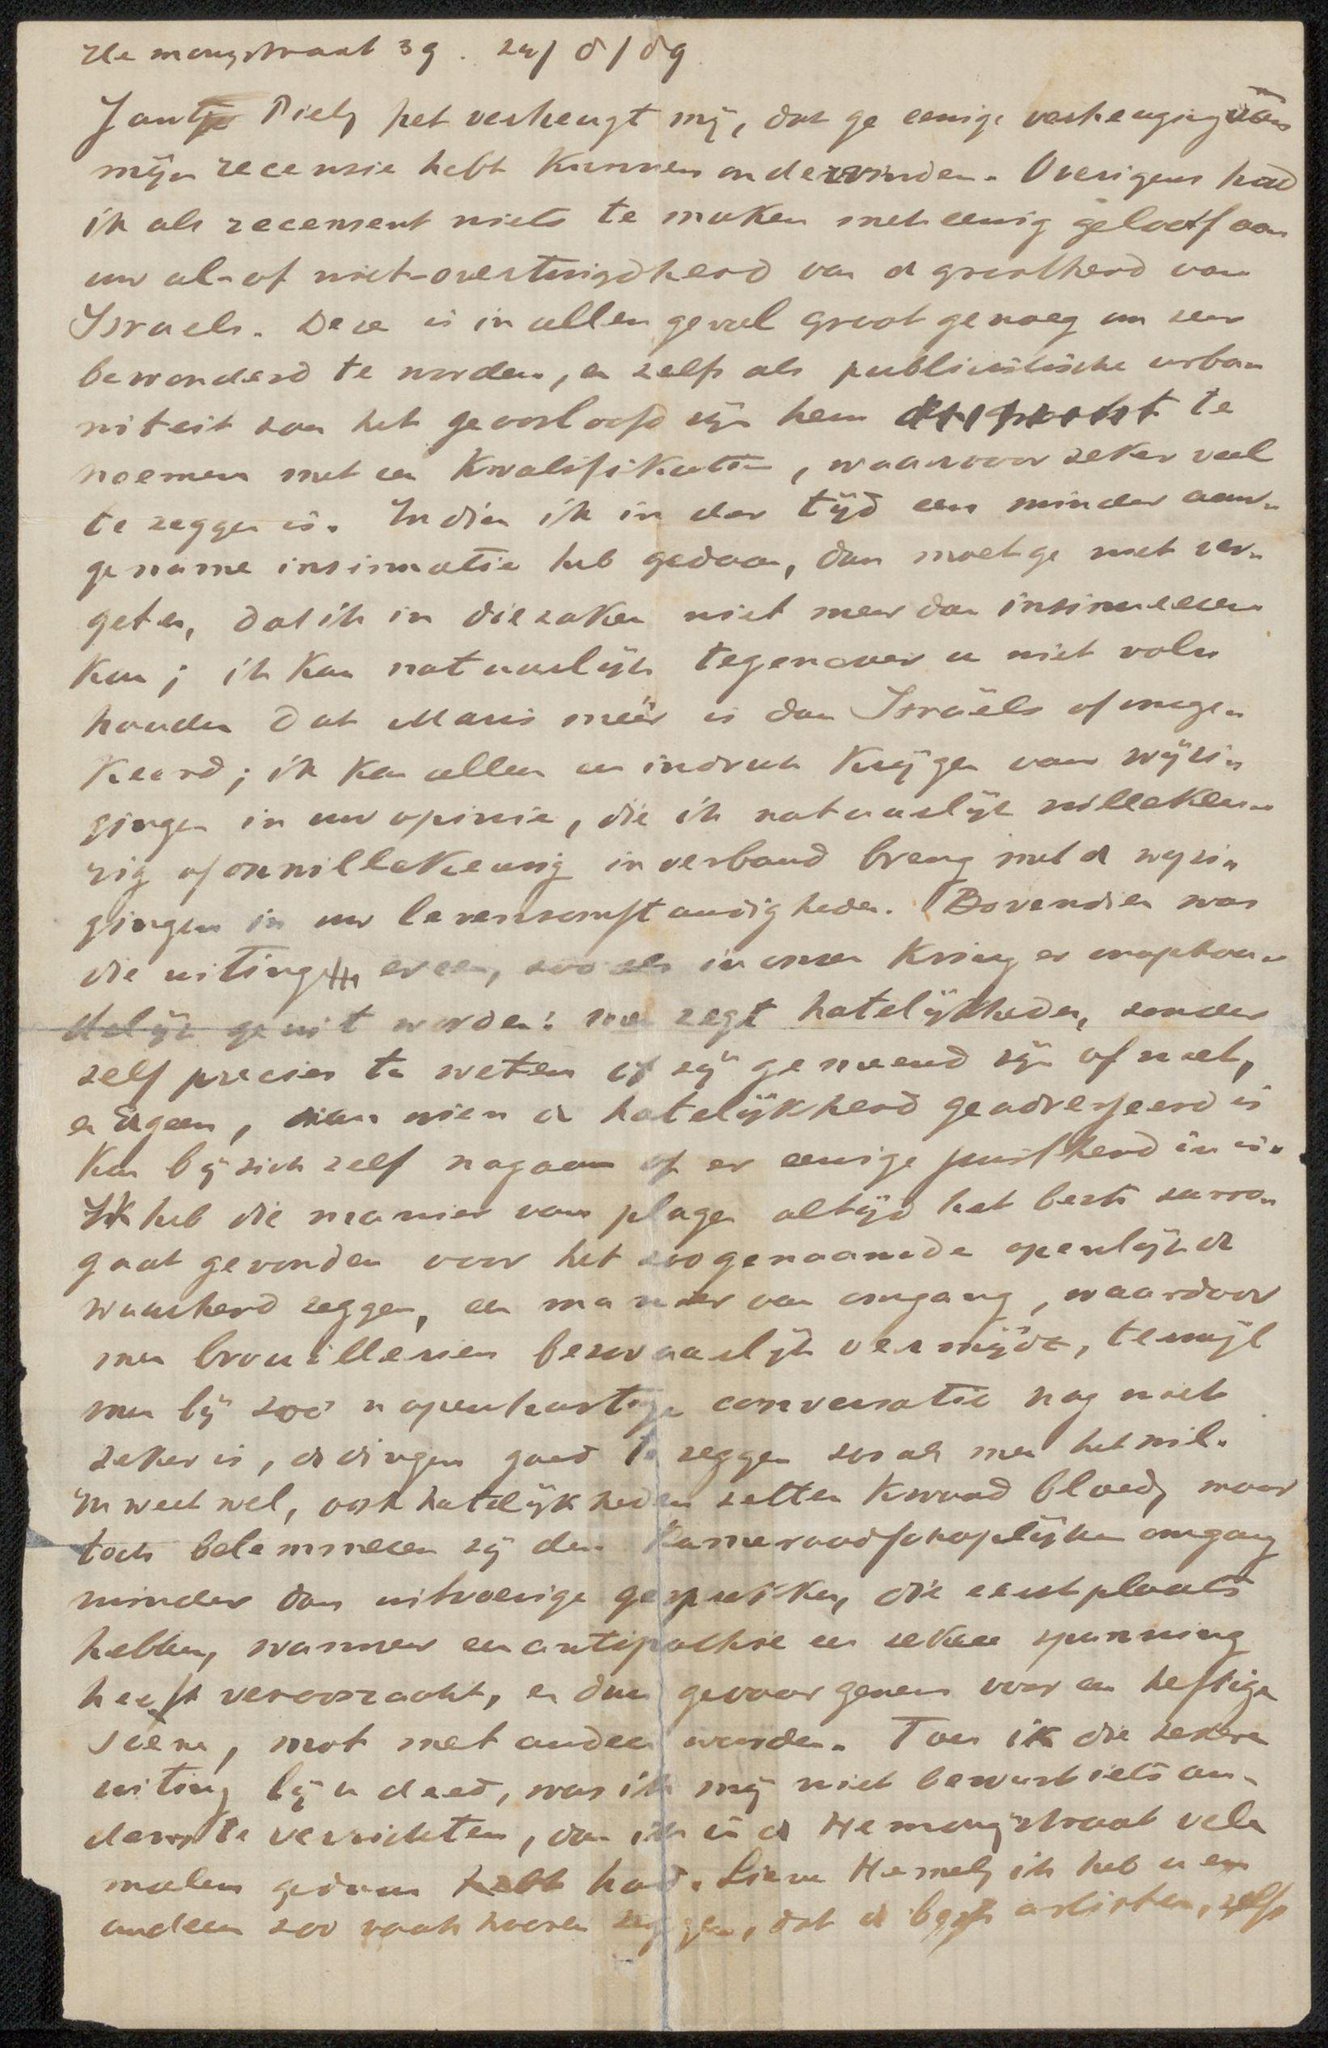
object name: letter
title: Brief aan Jan Veth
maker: chap van deventer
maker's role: kunstcriticus, scheikundige, schrijver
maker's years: 1860-1931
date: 1889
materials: ink, paper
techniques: pen, writing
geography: amsterdam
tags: jozef israëls, designer, jan veth, arnhem, painter, print maker, draughtsman, anton mauve, willem witsen, artist, anna dorothea dirks, printed matter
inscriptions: collector's mark: ‘RPK’